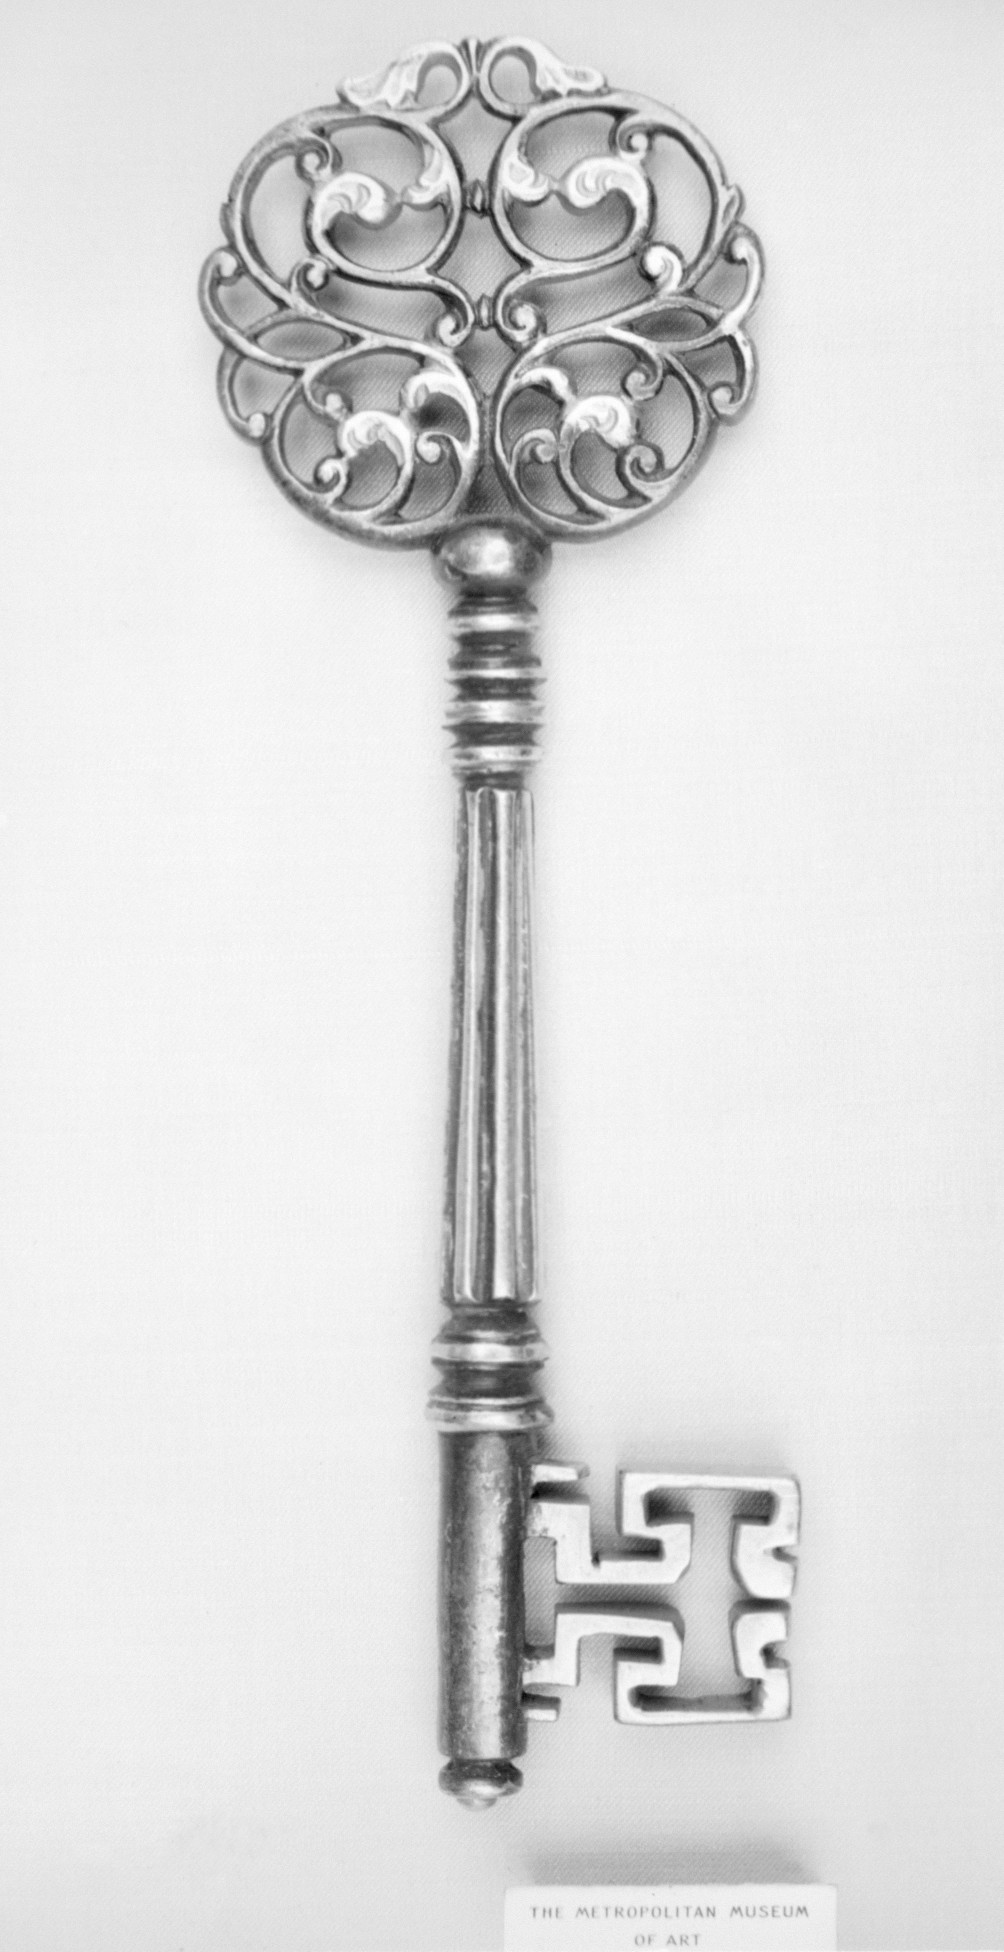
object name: key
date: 1701-1800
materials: brass